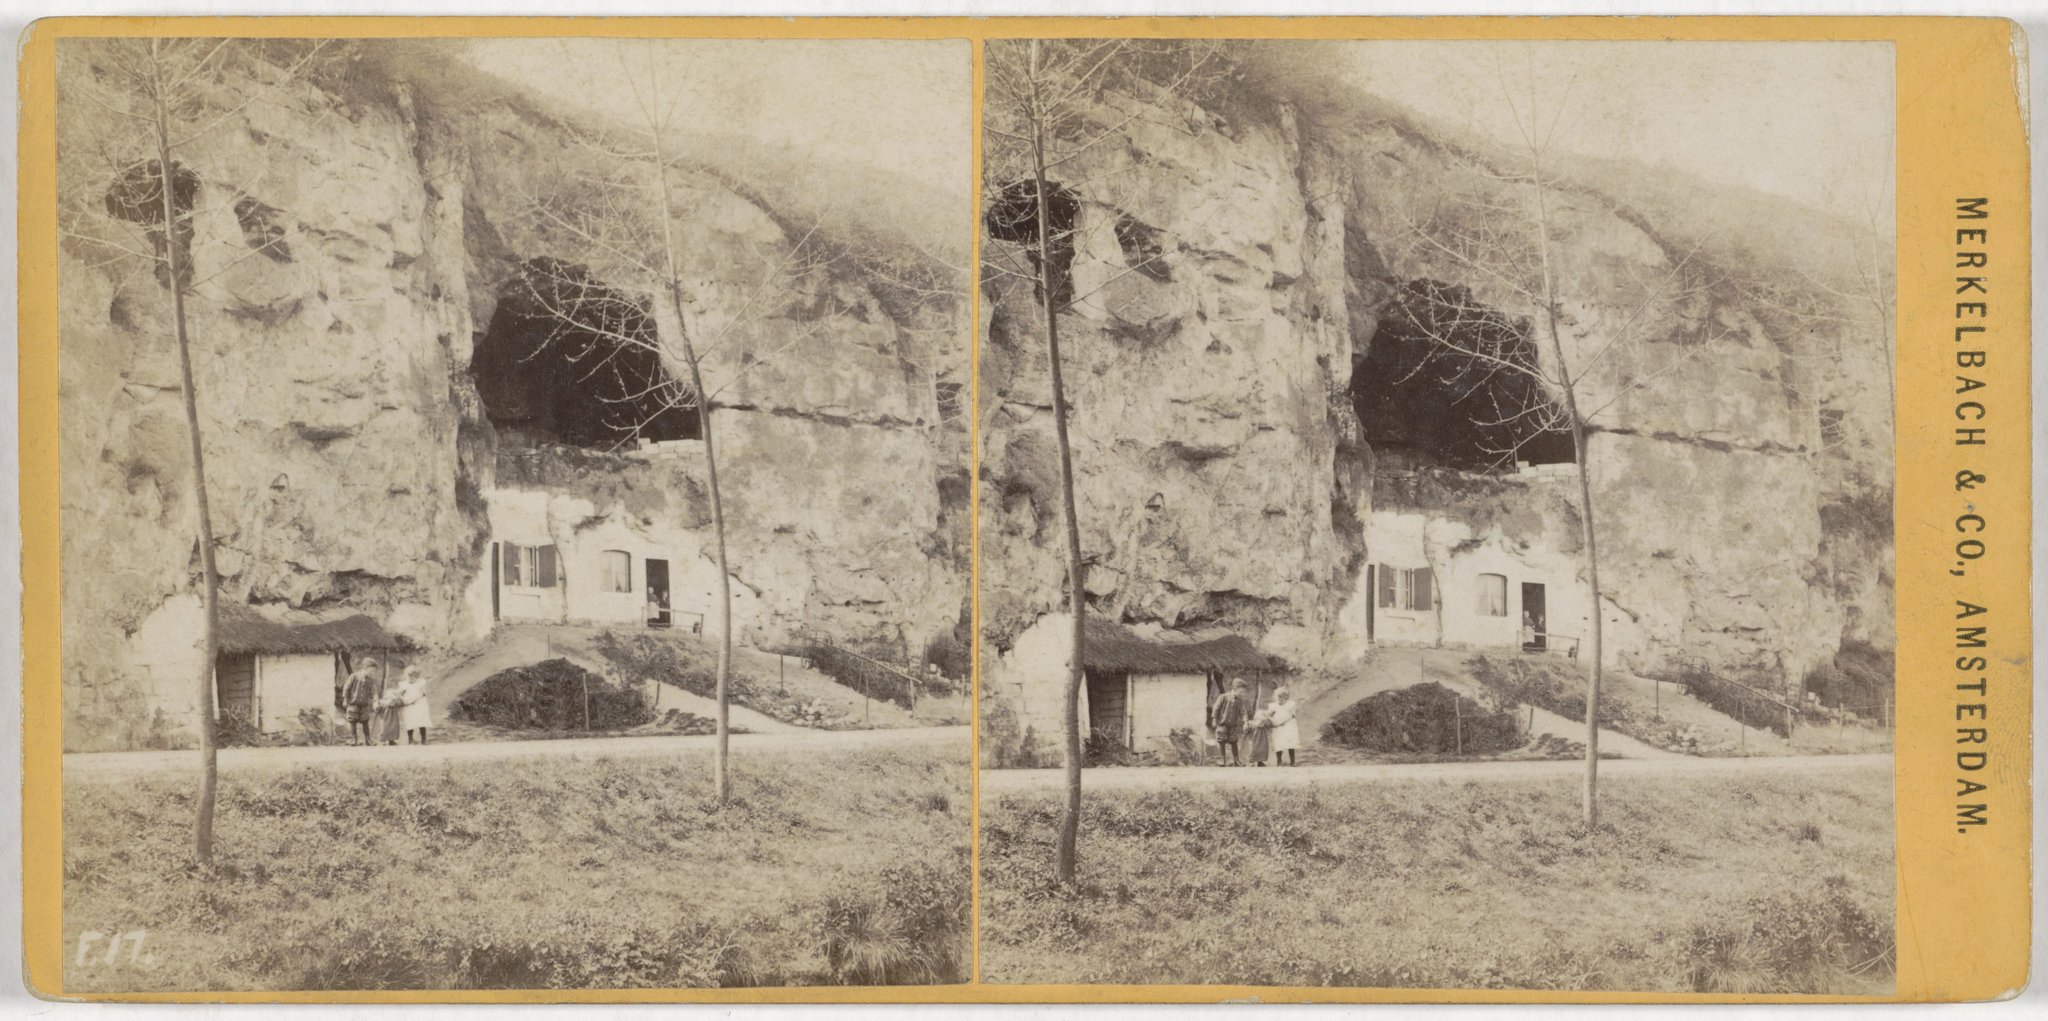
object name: stereograph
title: Gezicht op rotswoningen in Geulem, Limburg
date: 1900-1902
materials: cardboard, paper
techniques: albumen print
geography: geulhem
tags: cave-dwelling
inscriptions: inscription: ‘RBK’, inscription: ‘te Geulem, (zie pl. 16.) uitgegraven in den weeken steen. Warm en droog/ maar ... slecht geventileerd!’, number: ‘F.17.’, number: ‘17.’